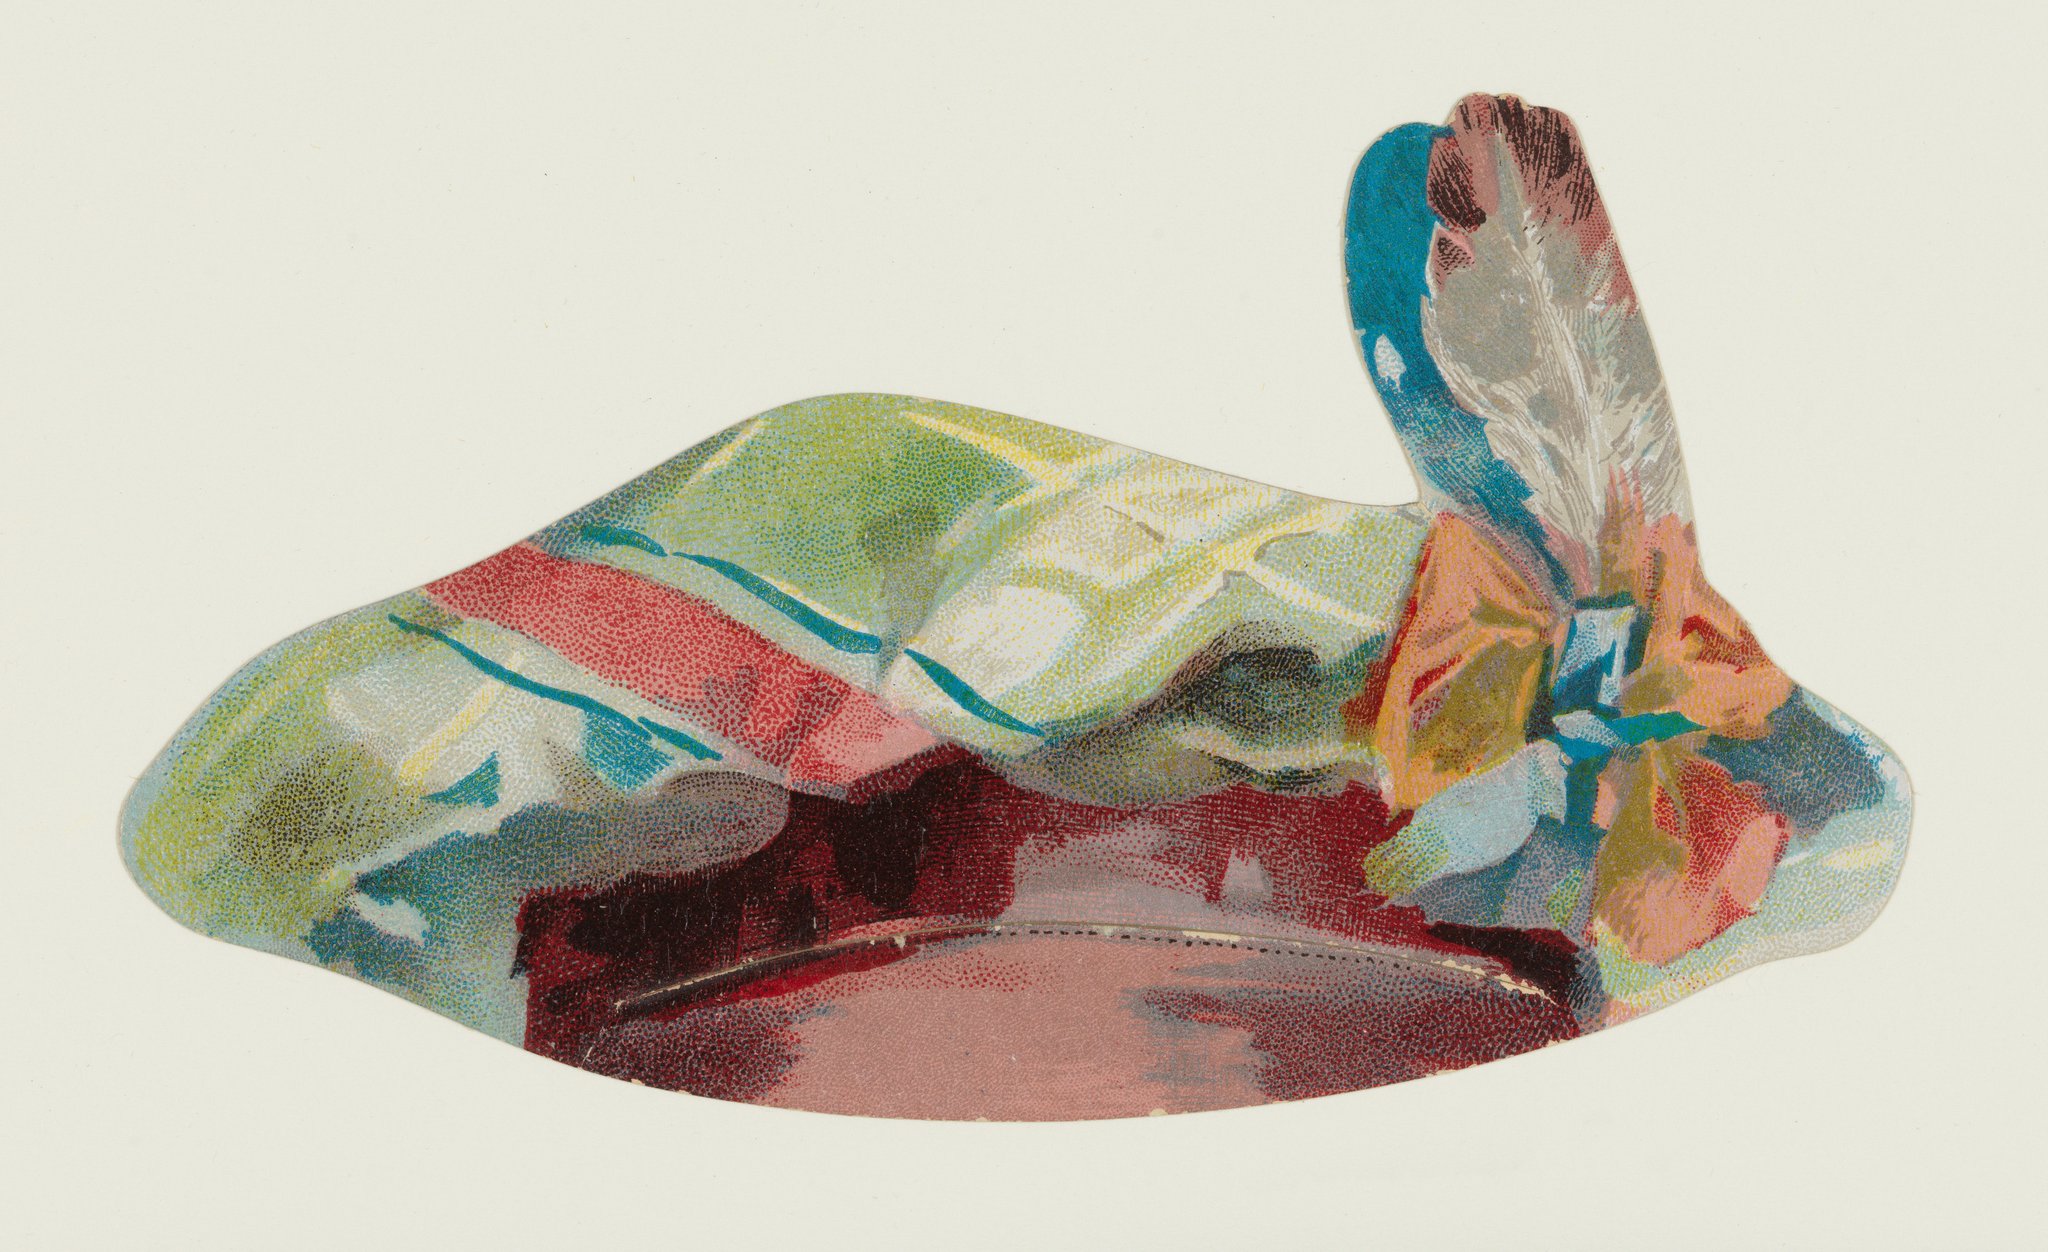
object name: paper doll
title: Our Favorite Dolls: Scottish Hat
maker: selchow and righter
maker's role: publisher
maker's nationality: american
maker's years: 1880-1986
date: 1900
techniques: lithograph